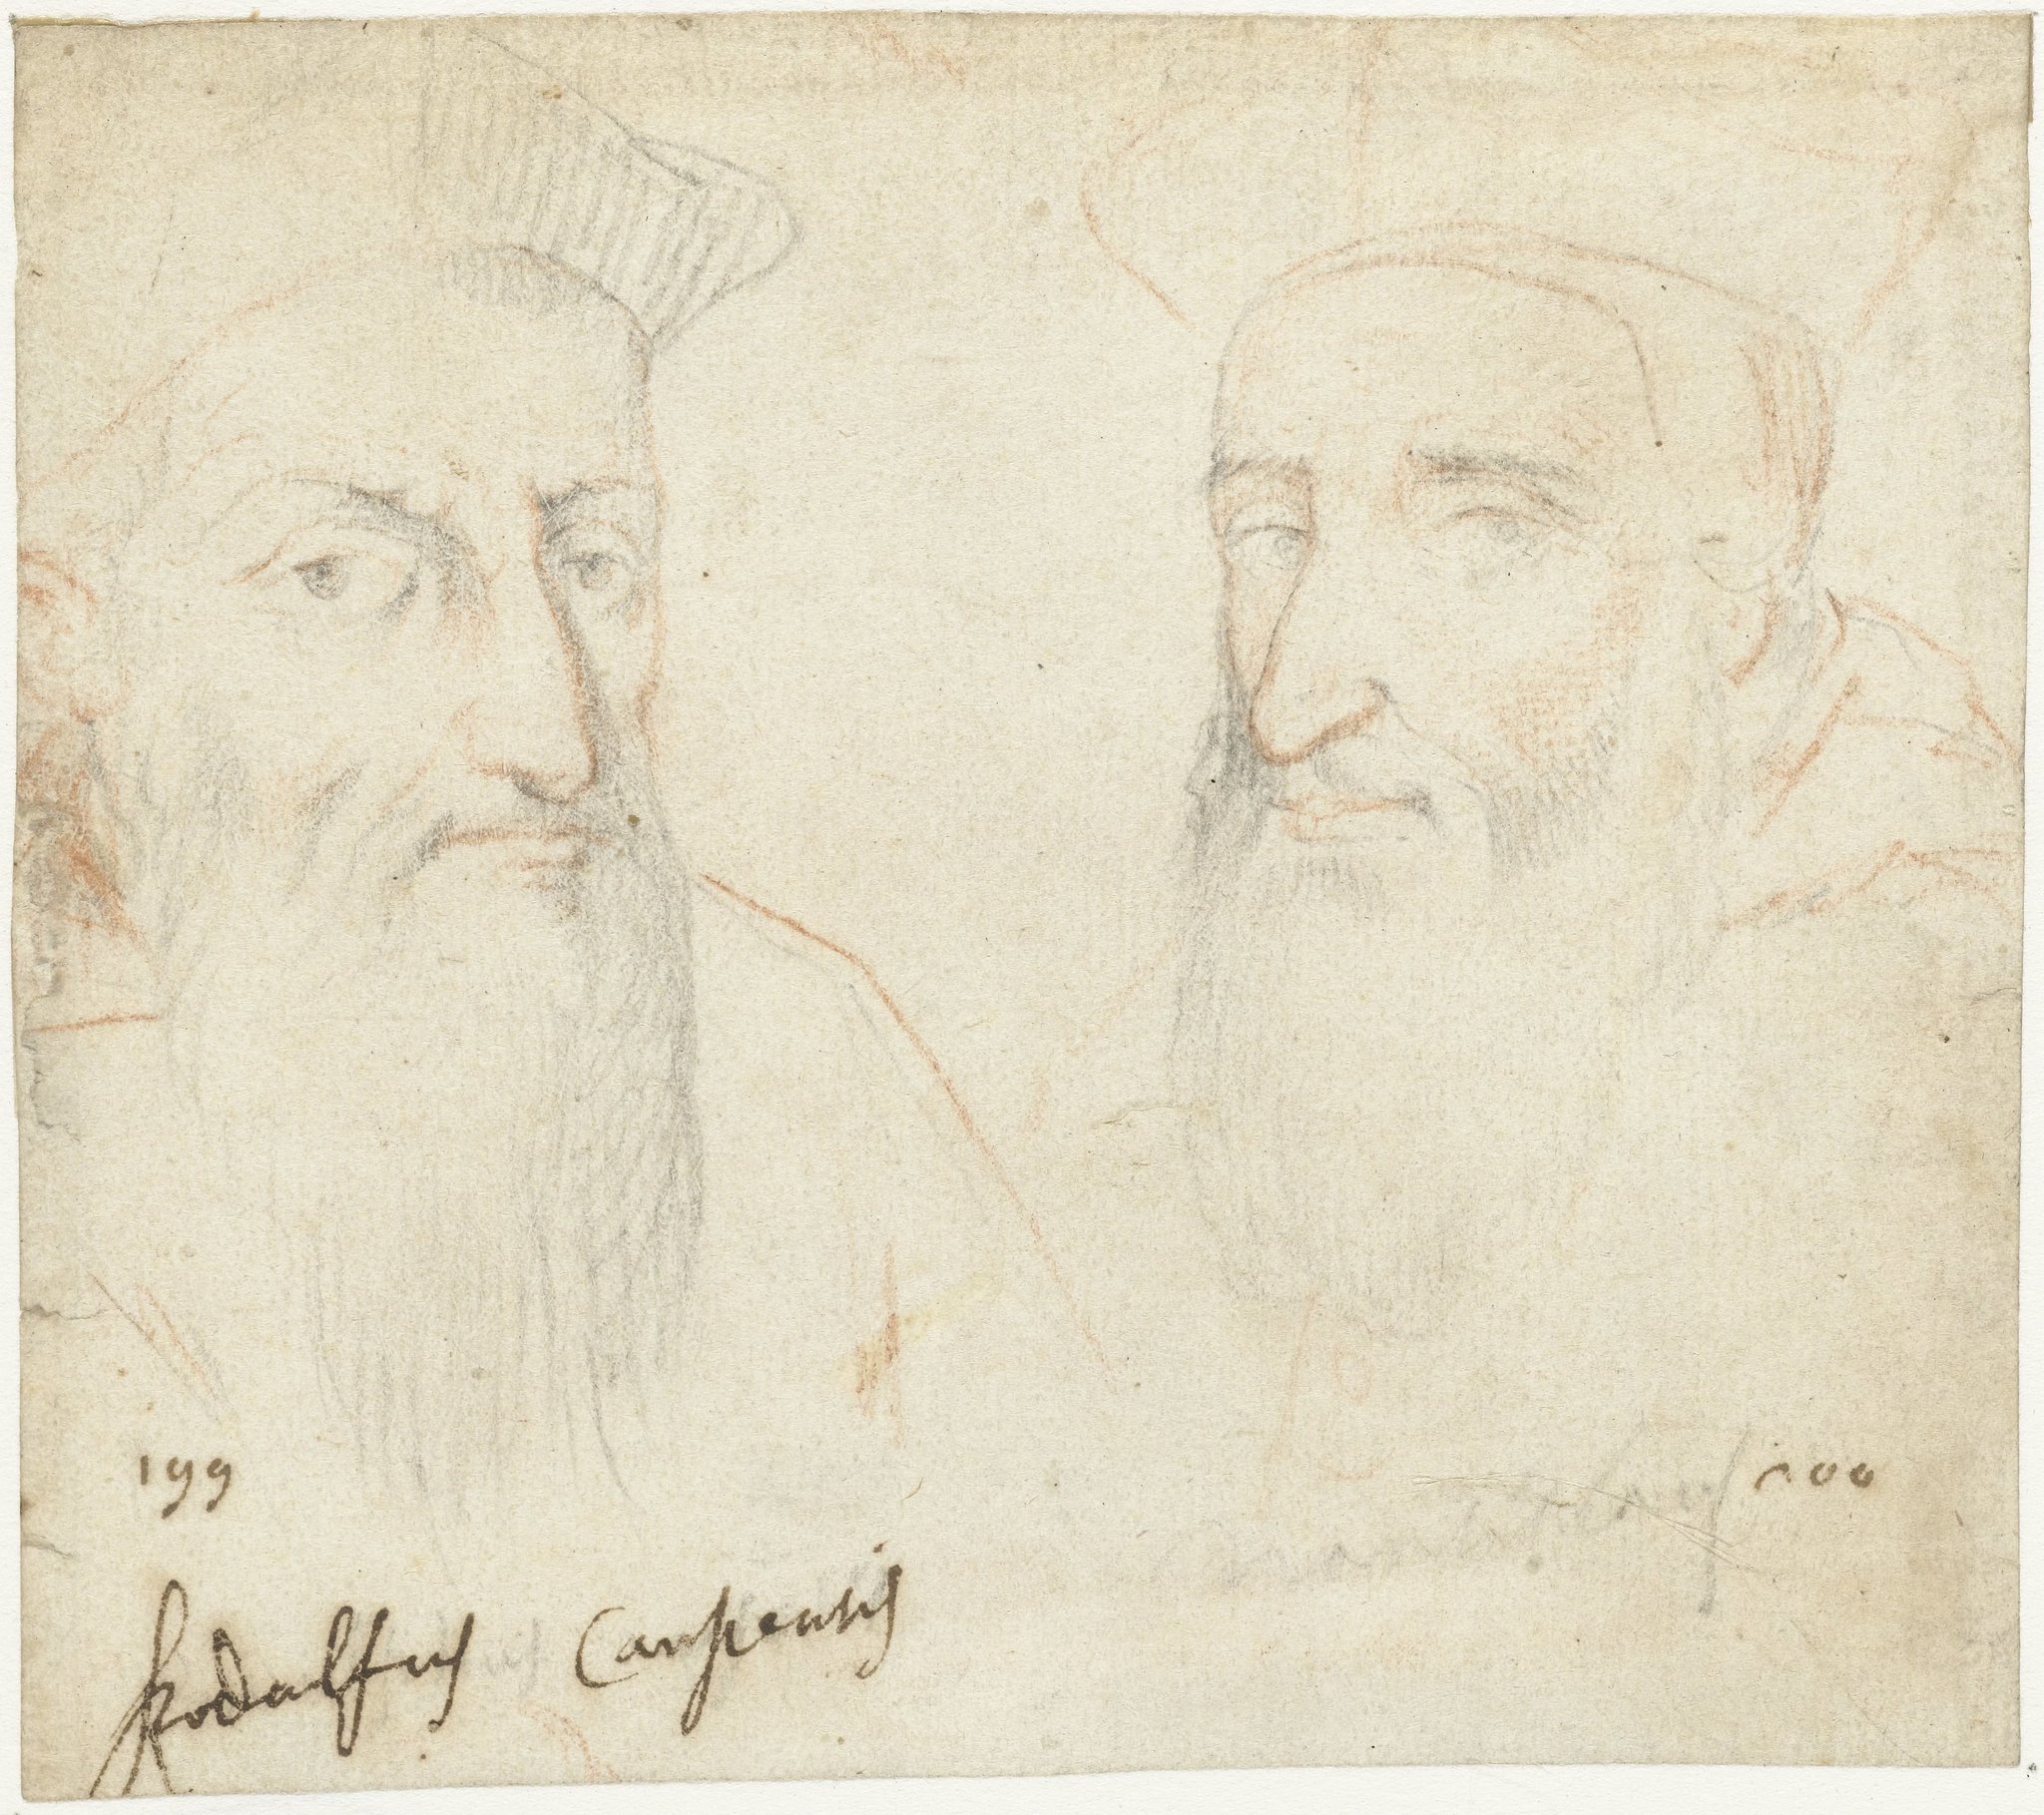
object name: drawing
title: Twee portretten van kardinalen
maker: federico zuccaro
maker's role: draughtsman, print maker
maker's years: 1540-1609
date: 1550-1609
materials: chalk, paper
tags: kardinaal, rodolfus carpensis